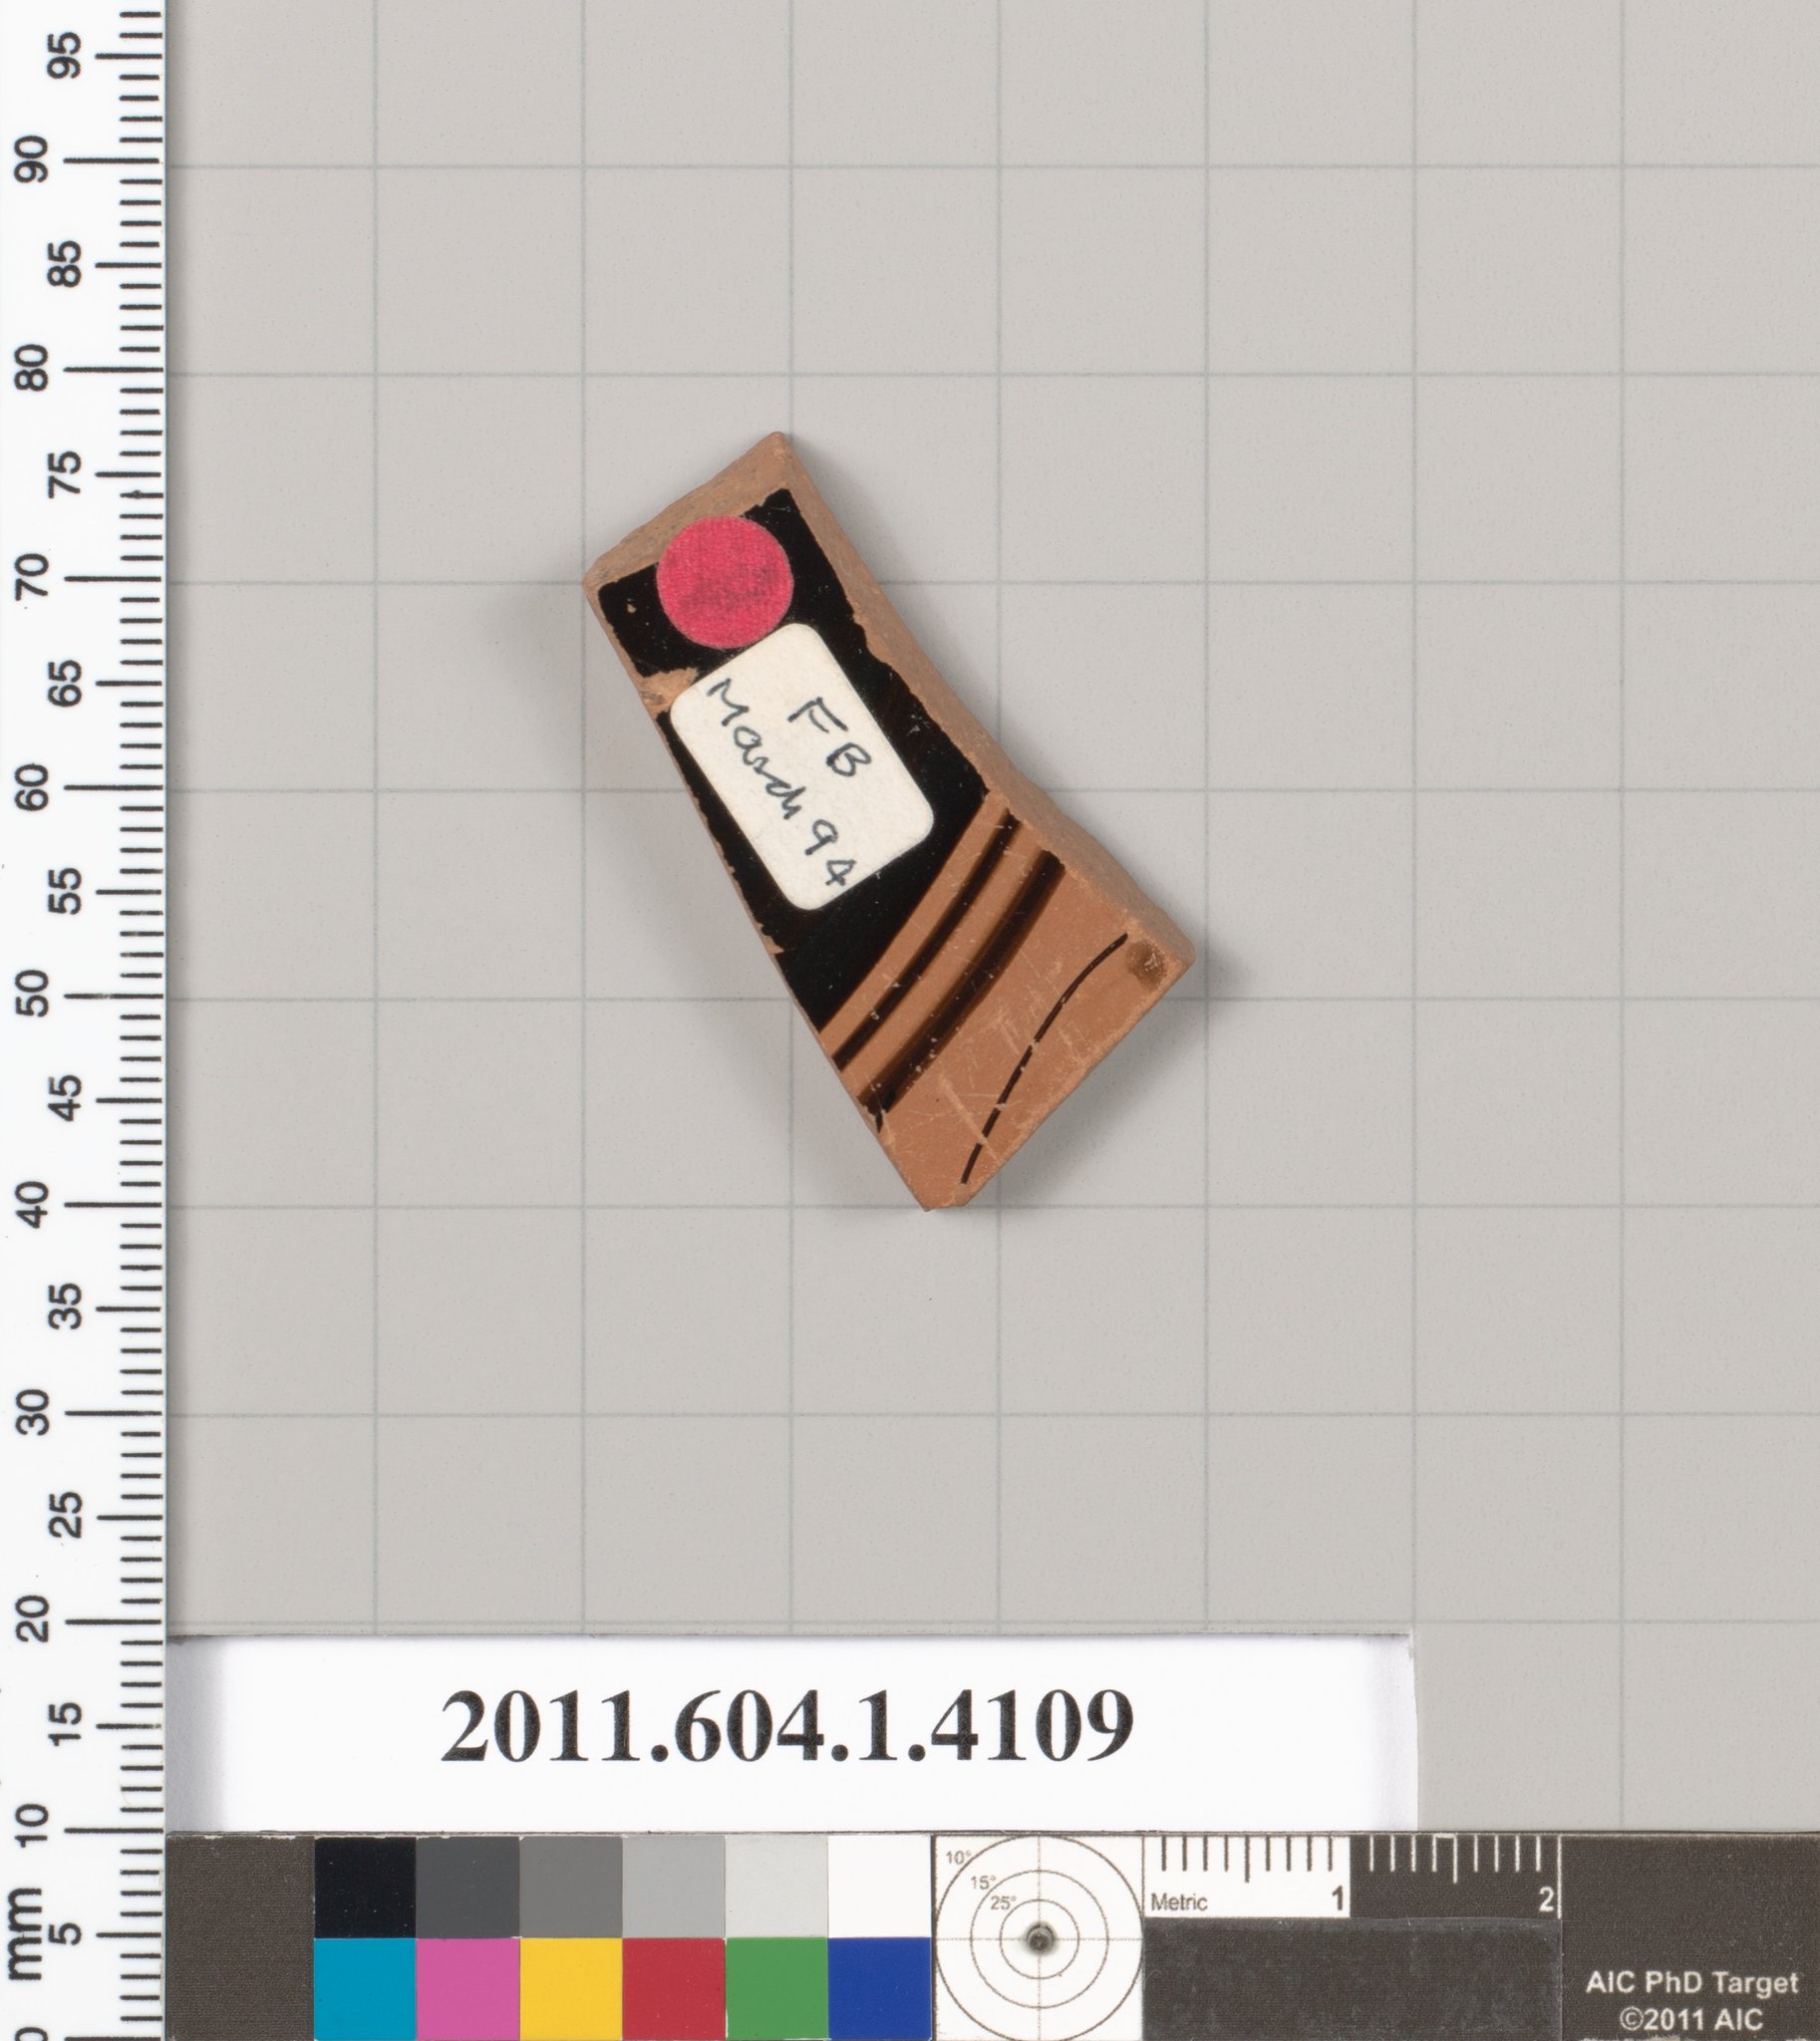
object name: kylix fragment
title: Terracotta fragment of a kylix (drinking cup)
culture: greek, attic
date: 475-451 BCE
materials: terracotta